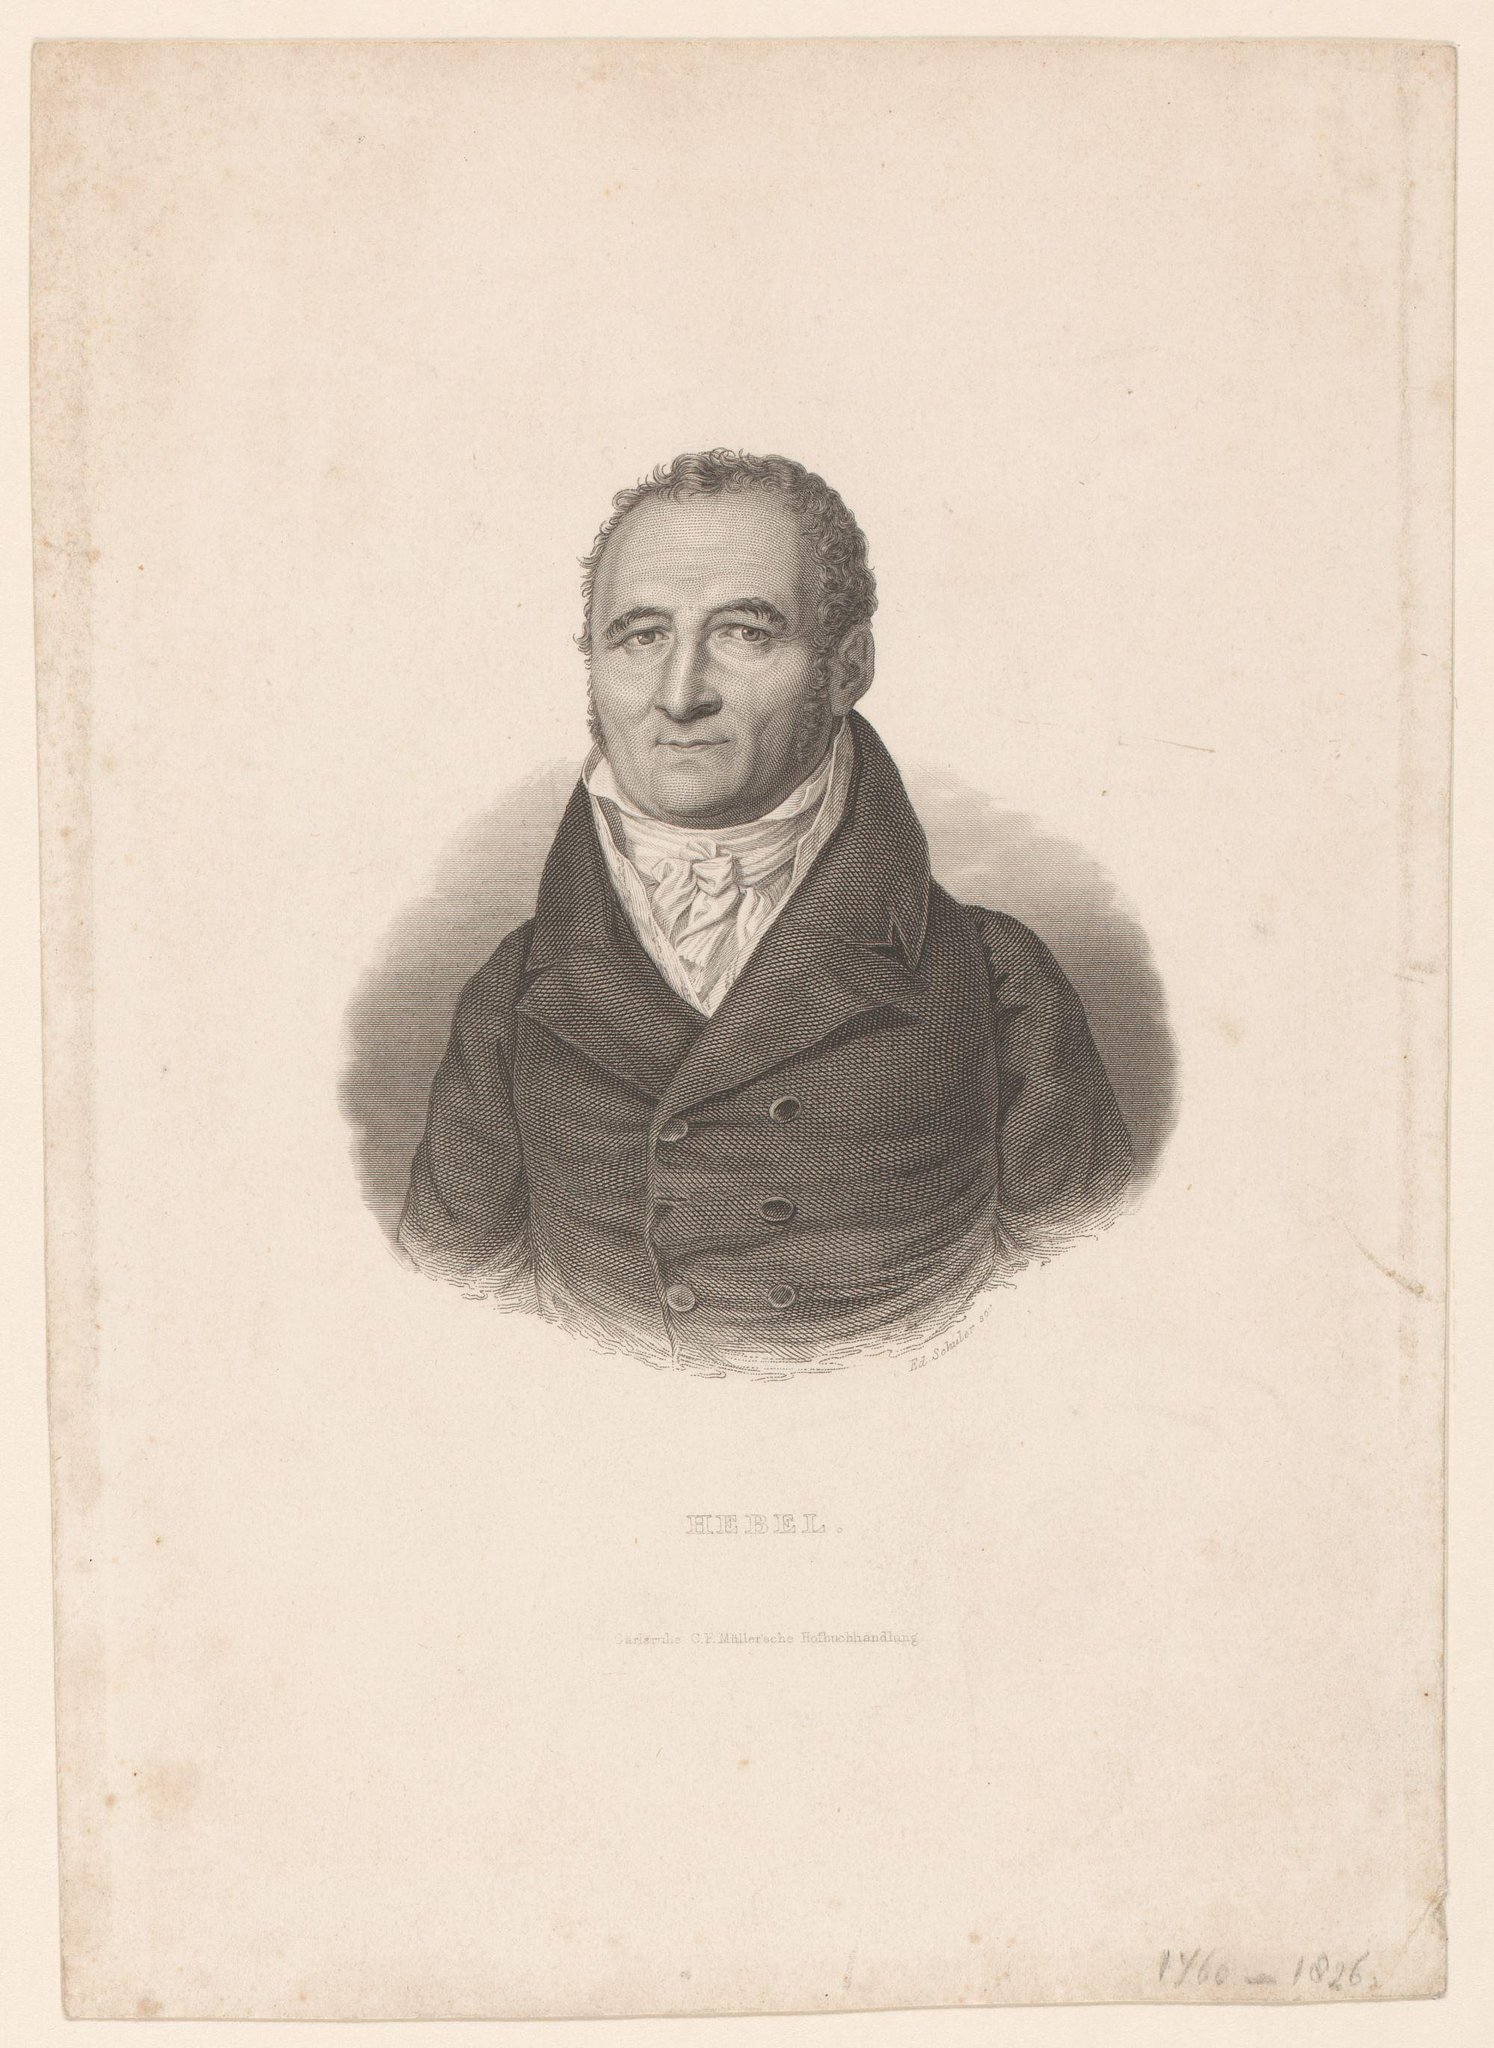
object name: print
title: Portret van Johann Peter Hebel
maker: edouard schuler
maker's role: print maker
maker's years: 1806-1882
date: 1816-1882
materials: paper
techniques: engraving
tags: historical persons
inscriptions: collector's mark: Lugt 2228